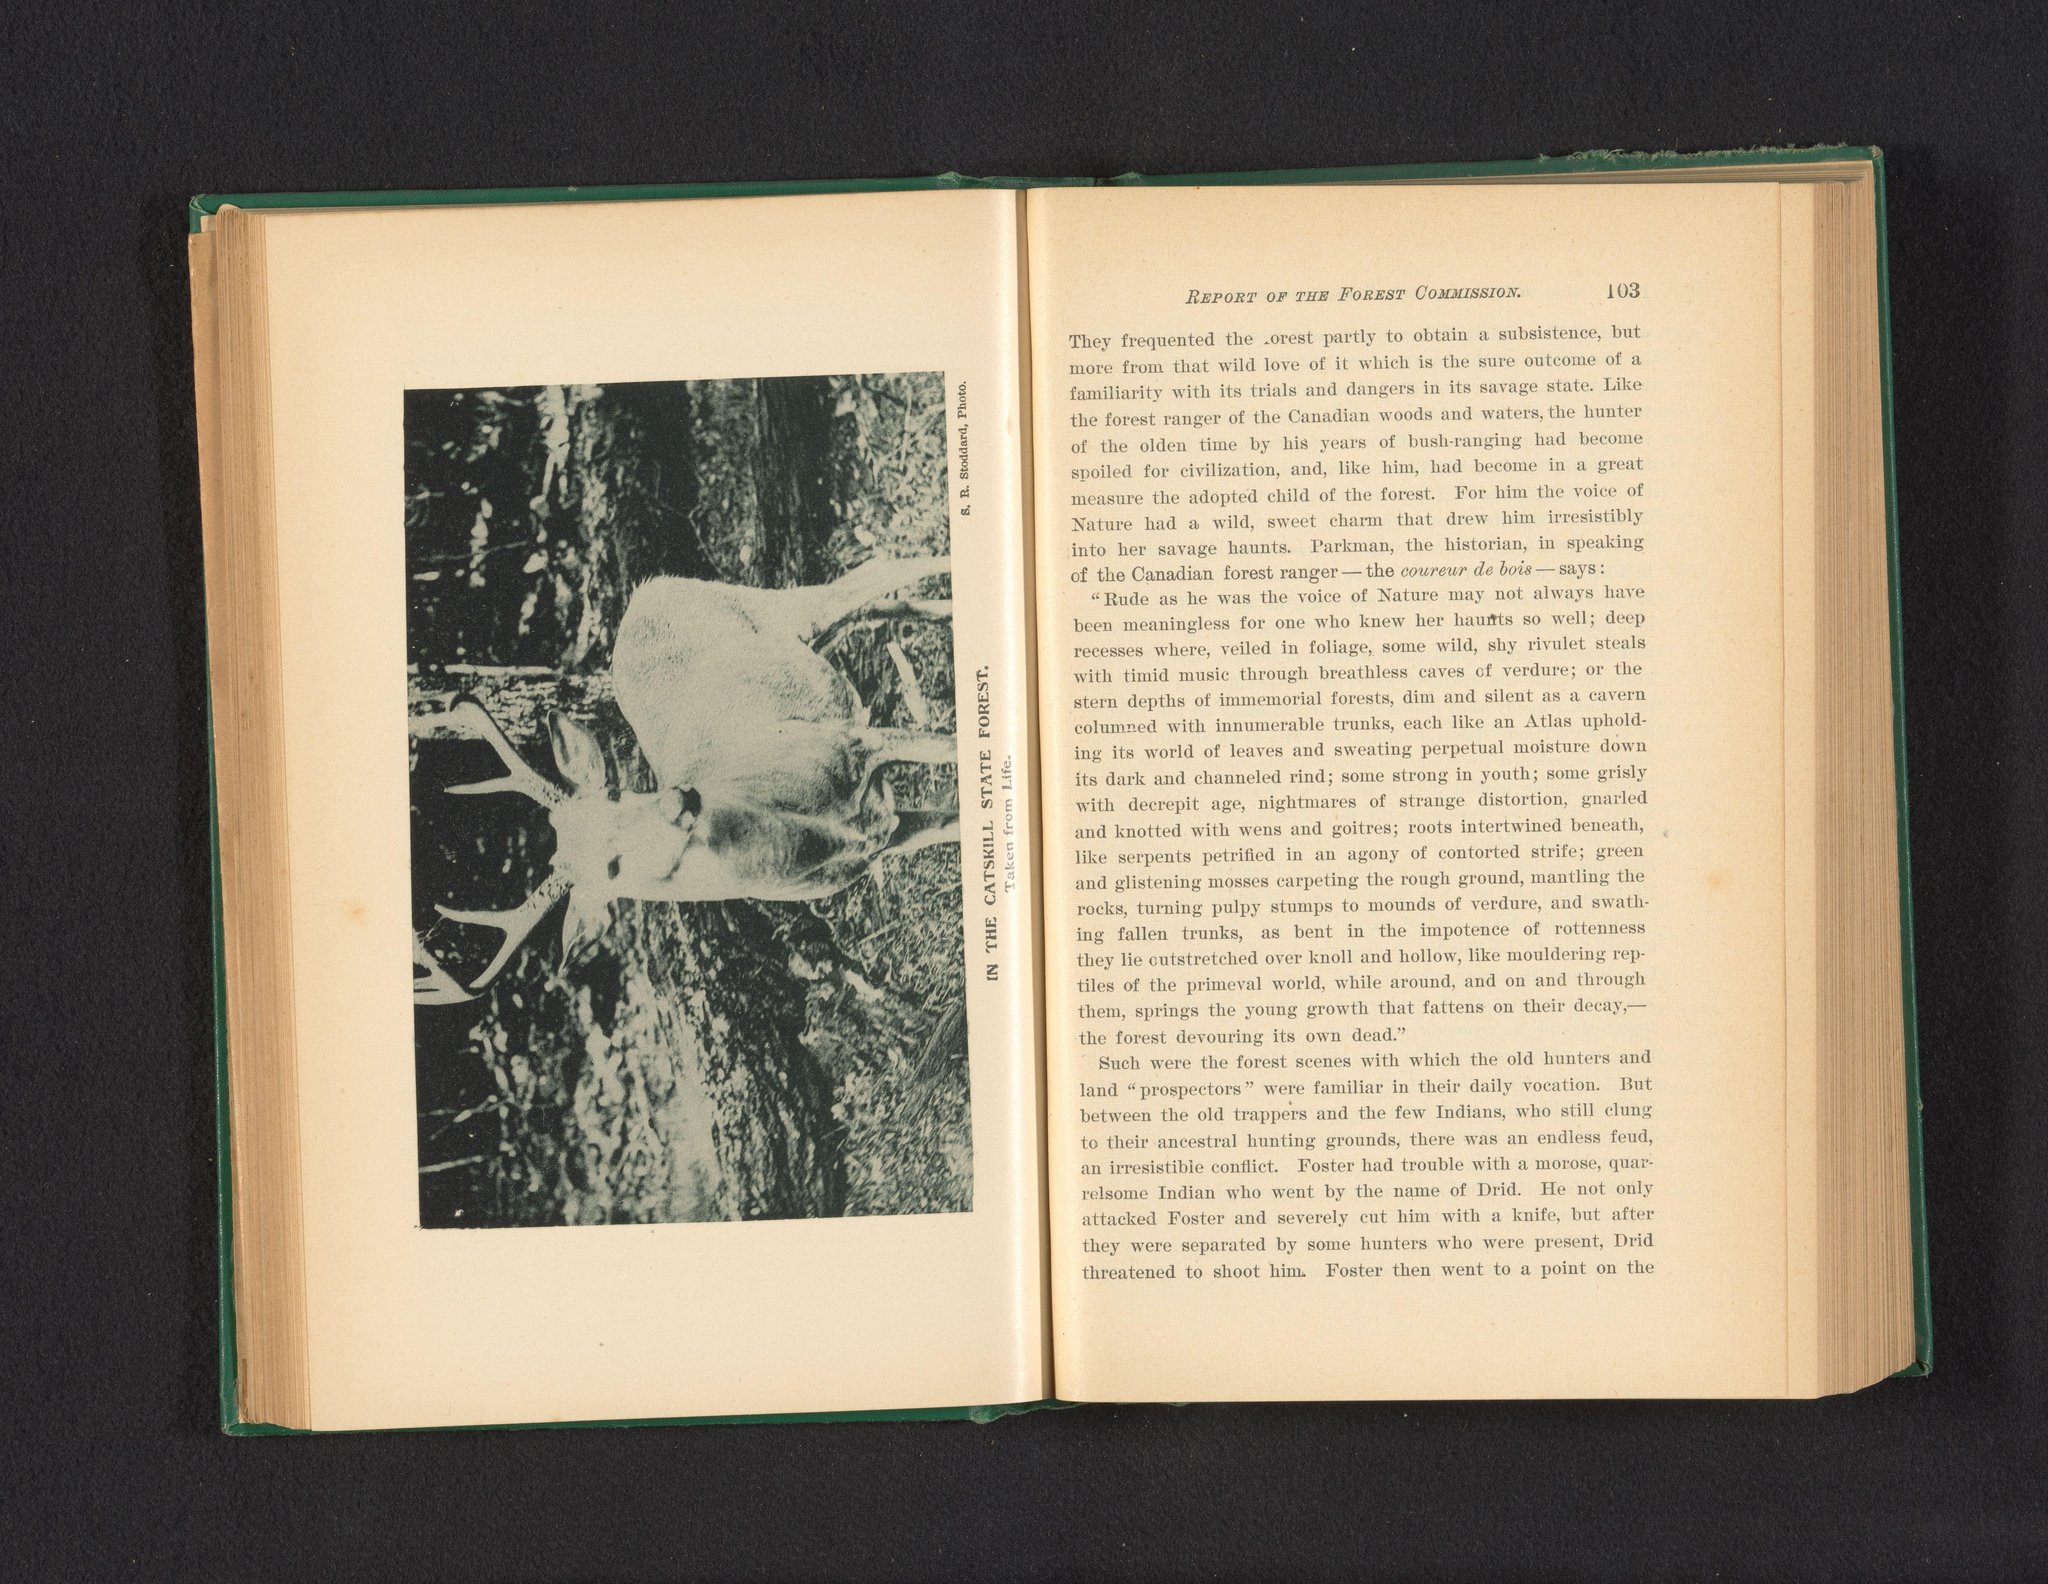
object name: page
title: In the Catskill state forest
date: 1893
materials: paper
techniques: photograph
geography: catskill mountains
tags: hoofed animals: deer